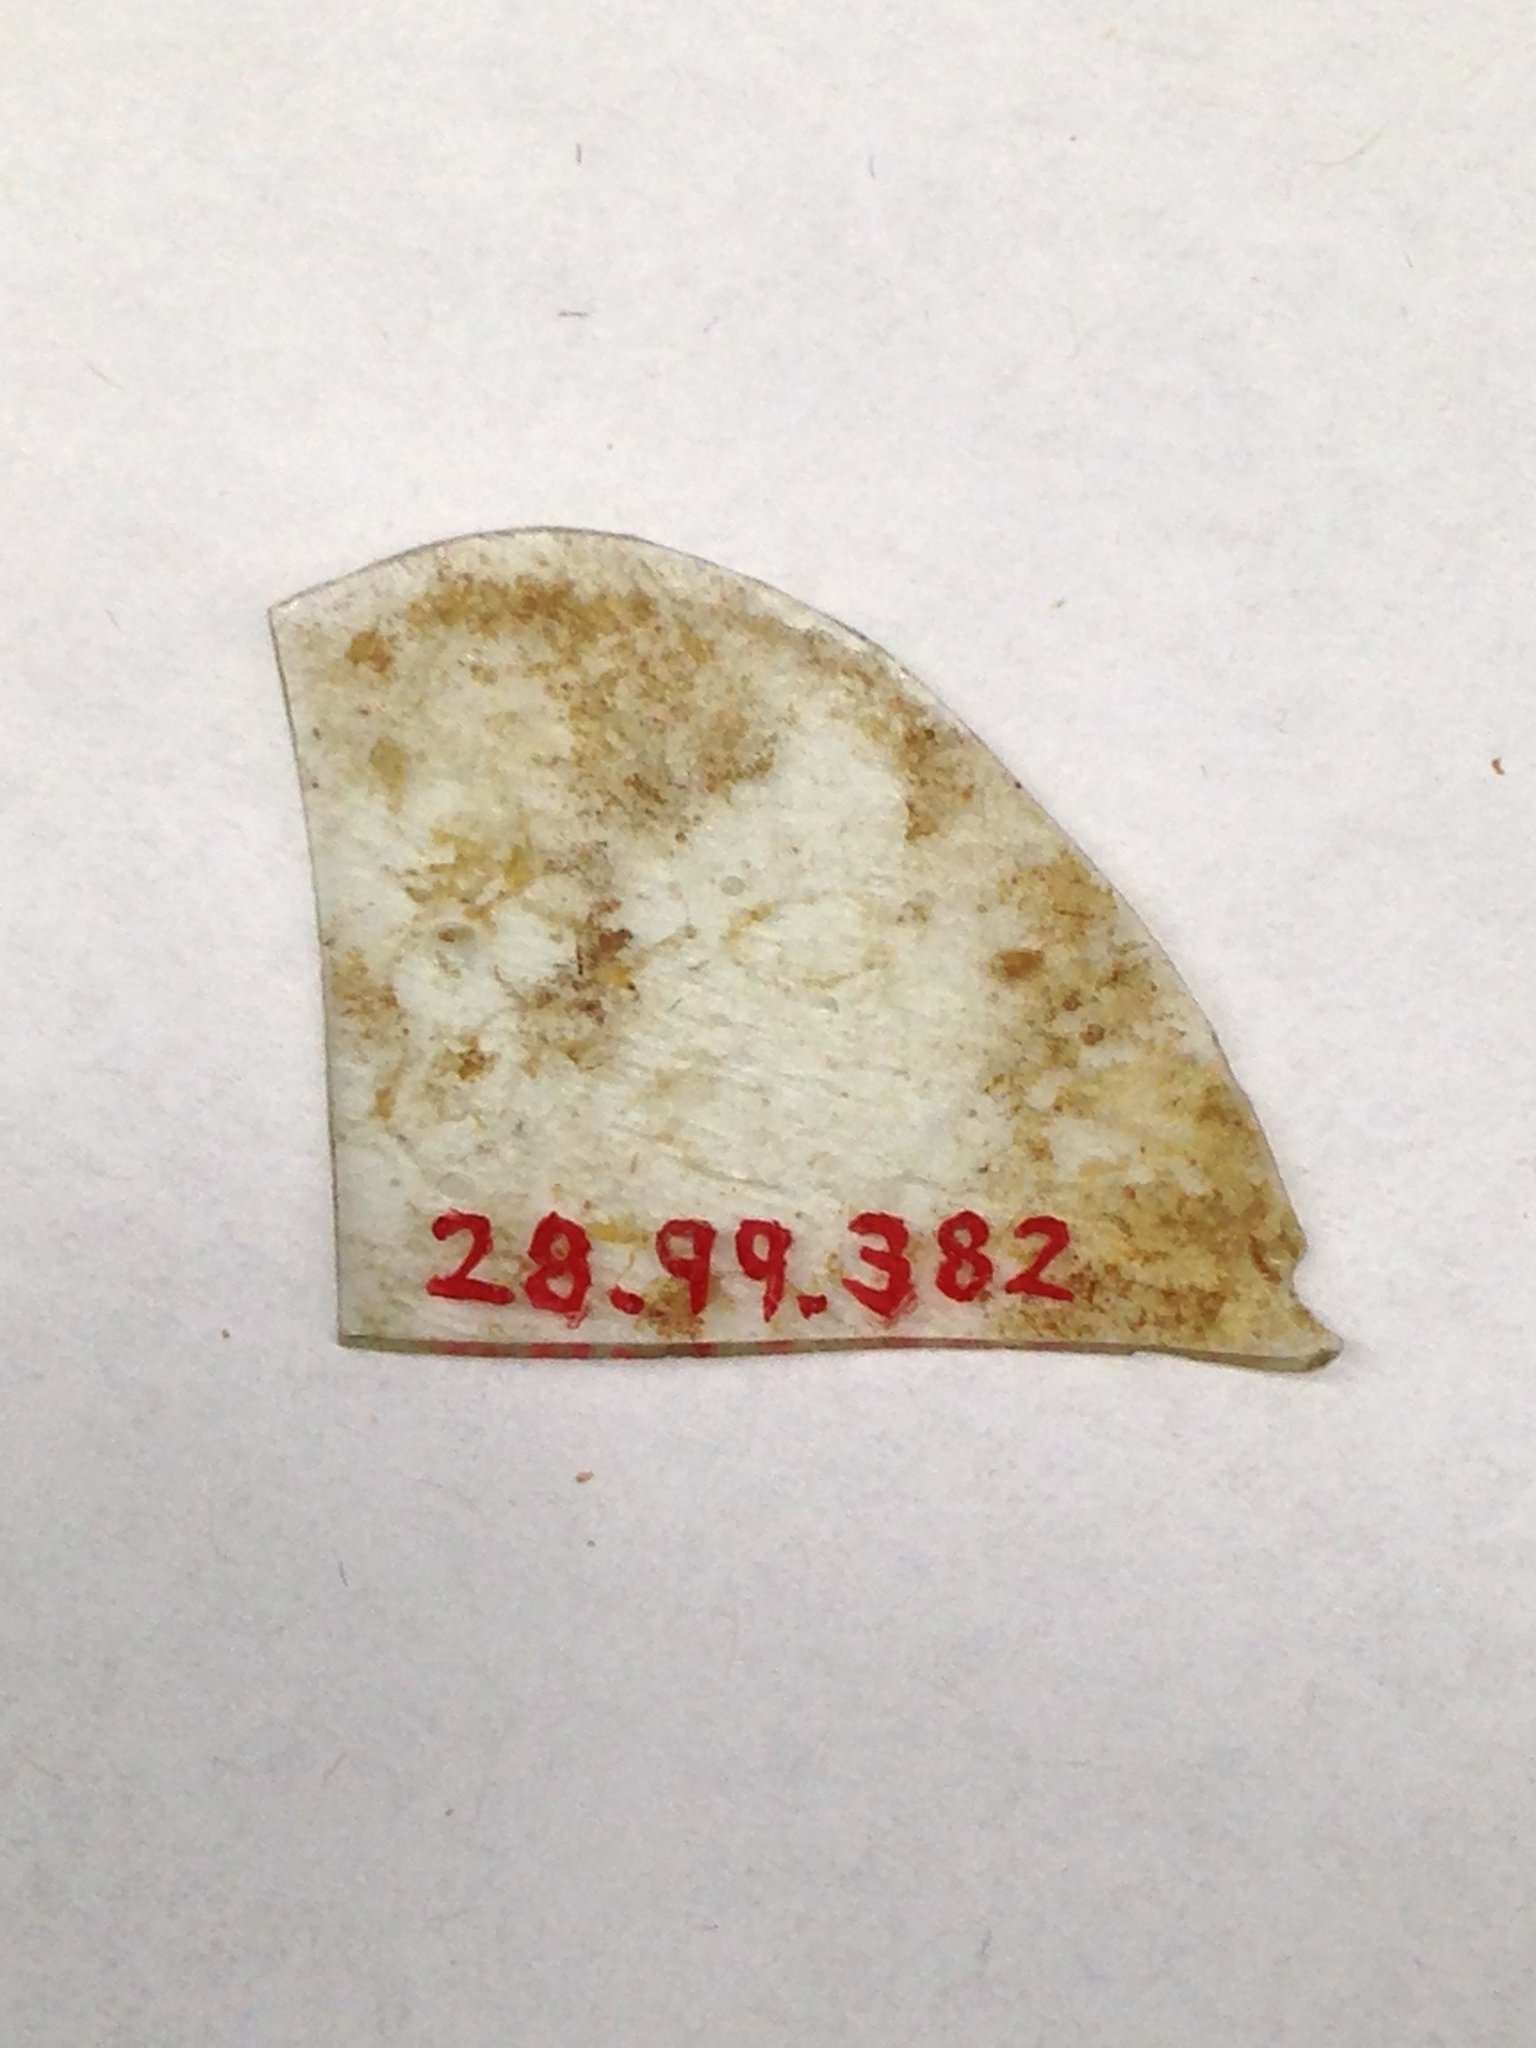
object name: fragment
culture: european or middle eastern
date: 1150-1250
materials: ceramic, glass